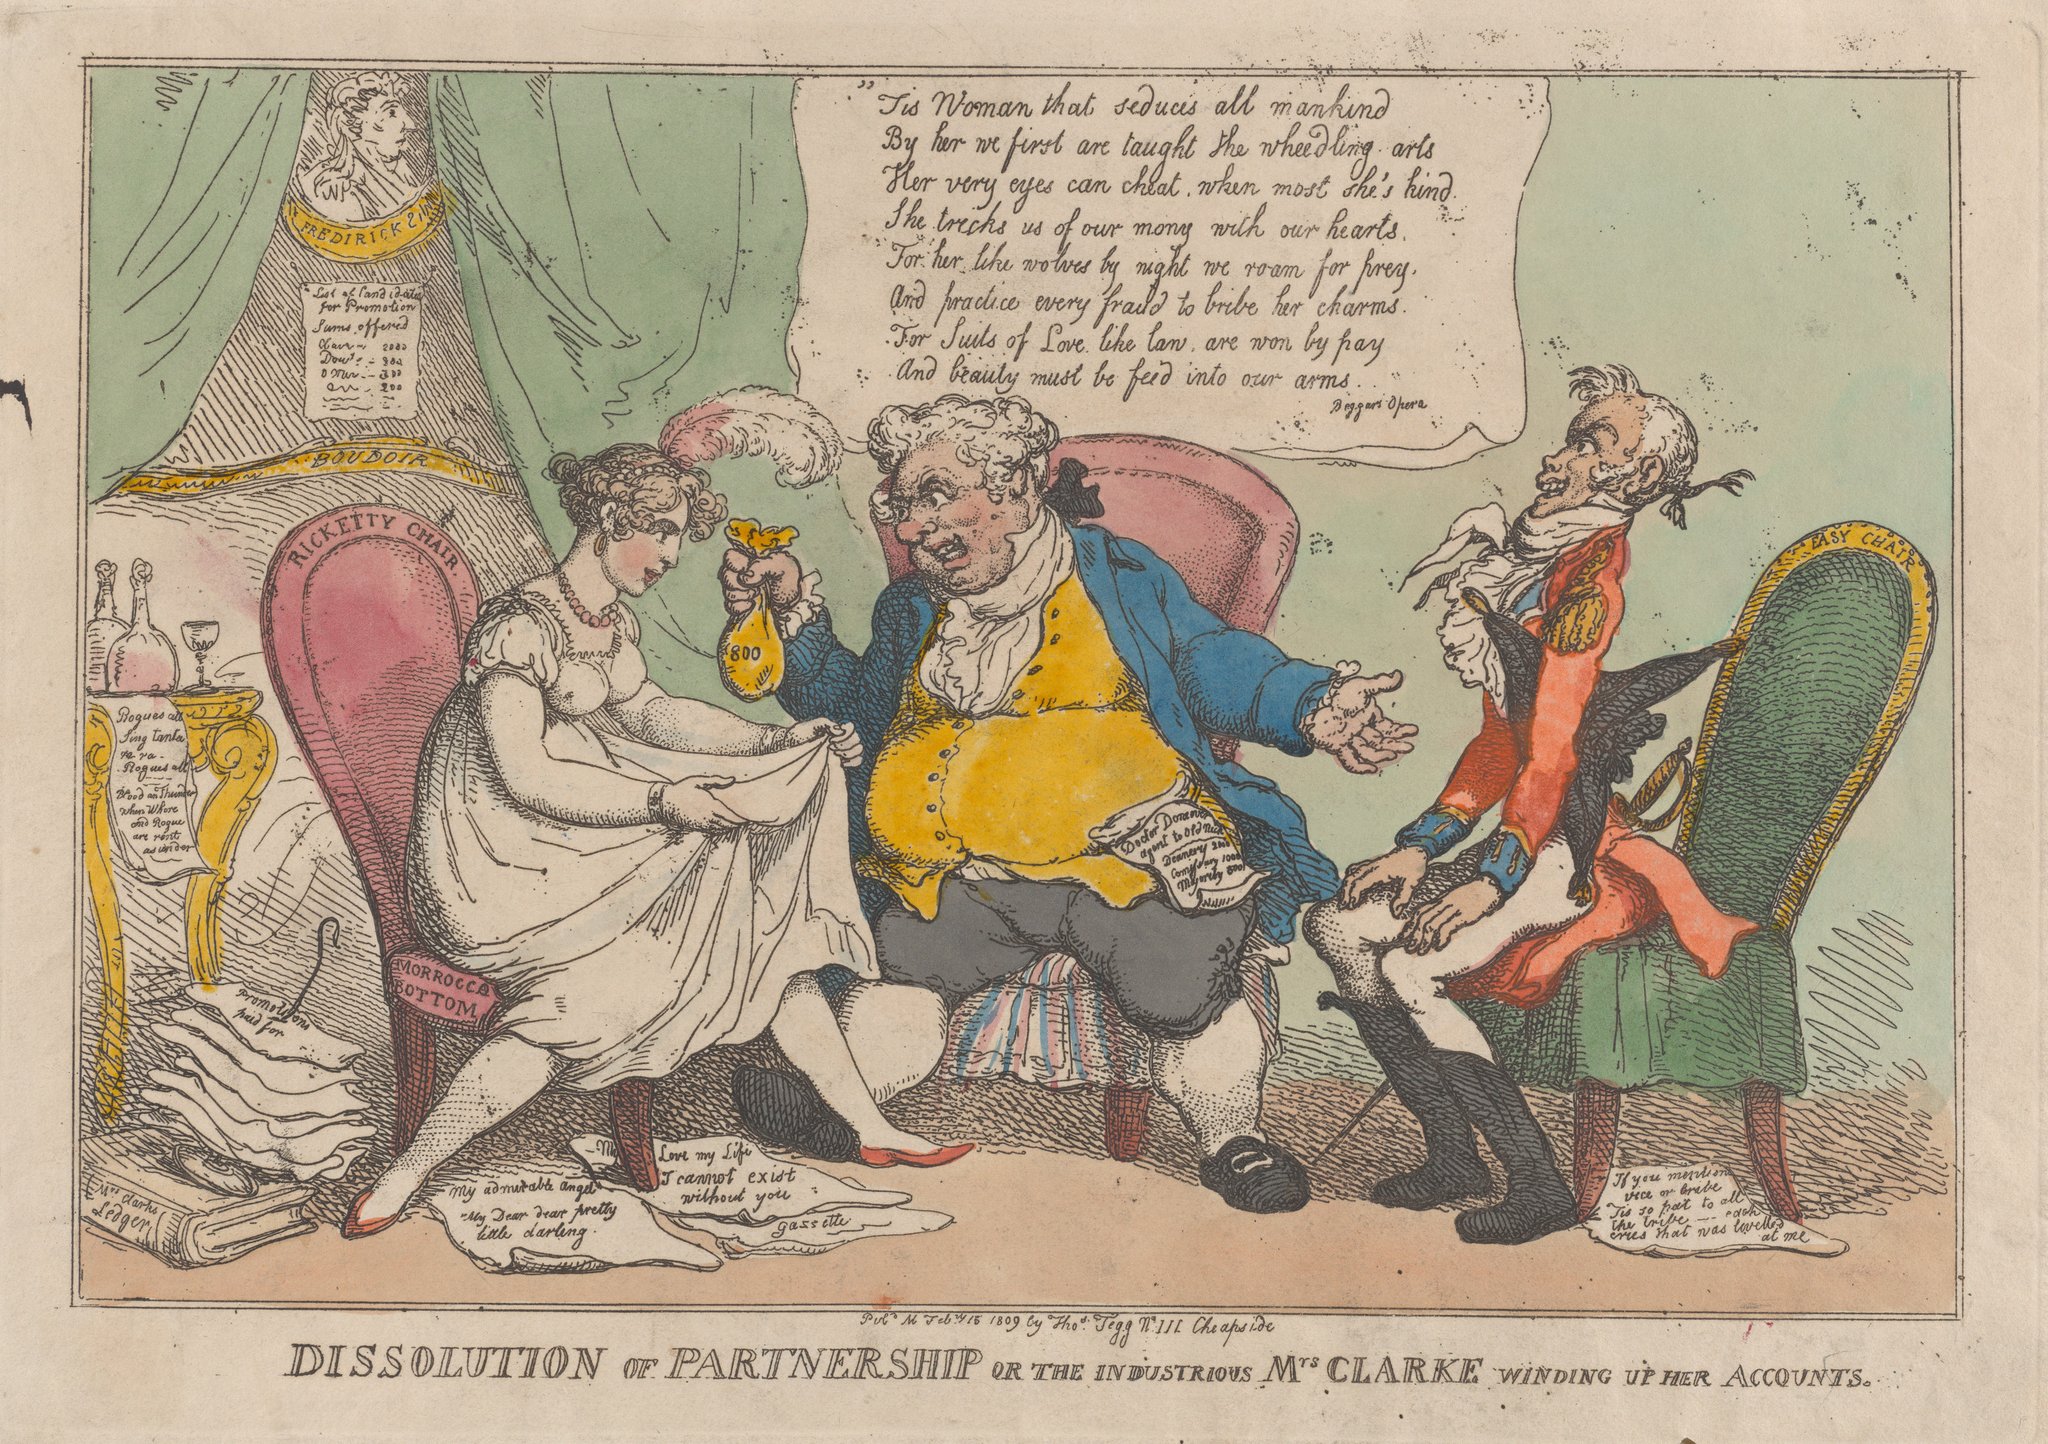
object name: print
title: Dissolution of Partnership, or the Industrious Mrs. Clarke Winding Up Her Accounts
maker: thomas rowlandson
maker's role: artist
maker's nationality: british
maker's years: 1757-1827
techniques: etching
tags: satire,men,women,money,politics